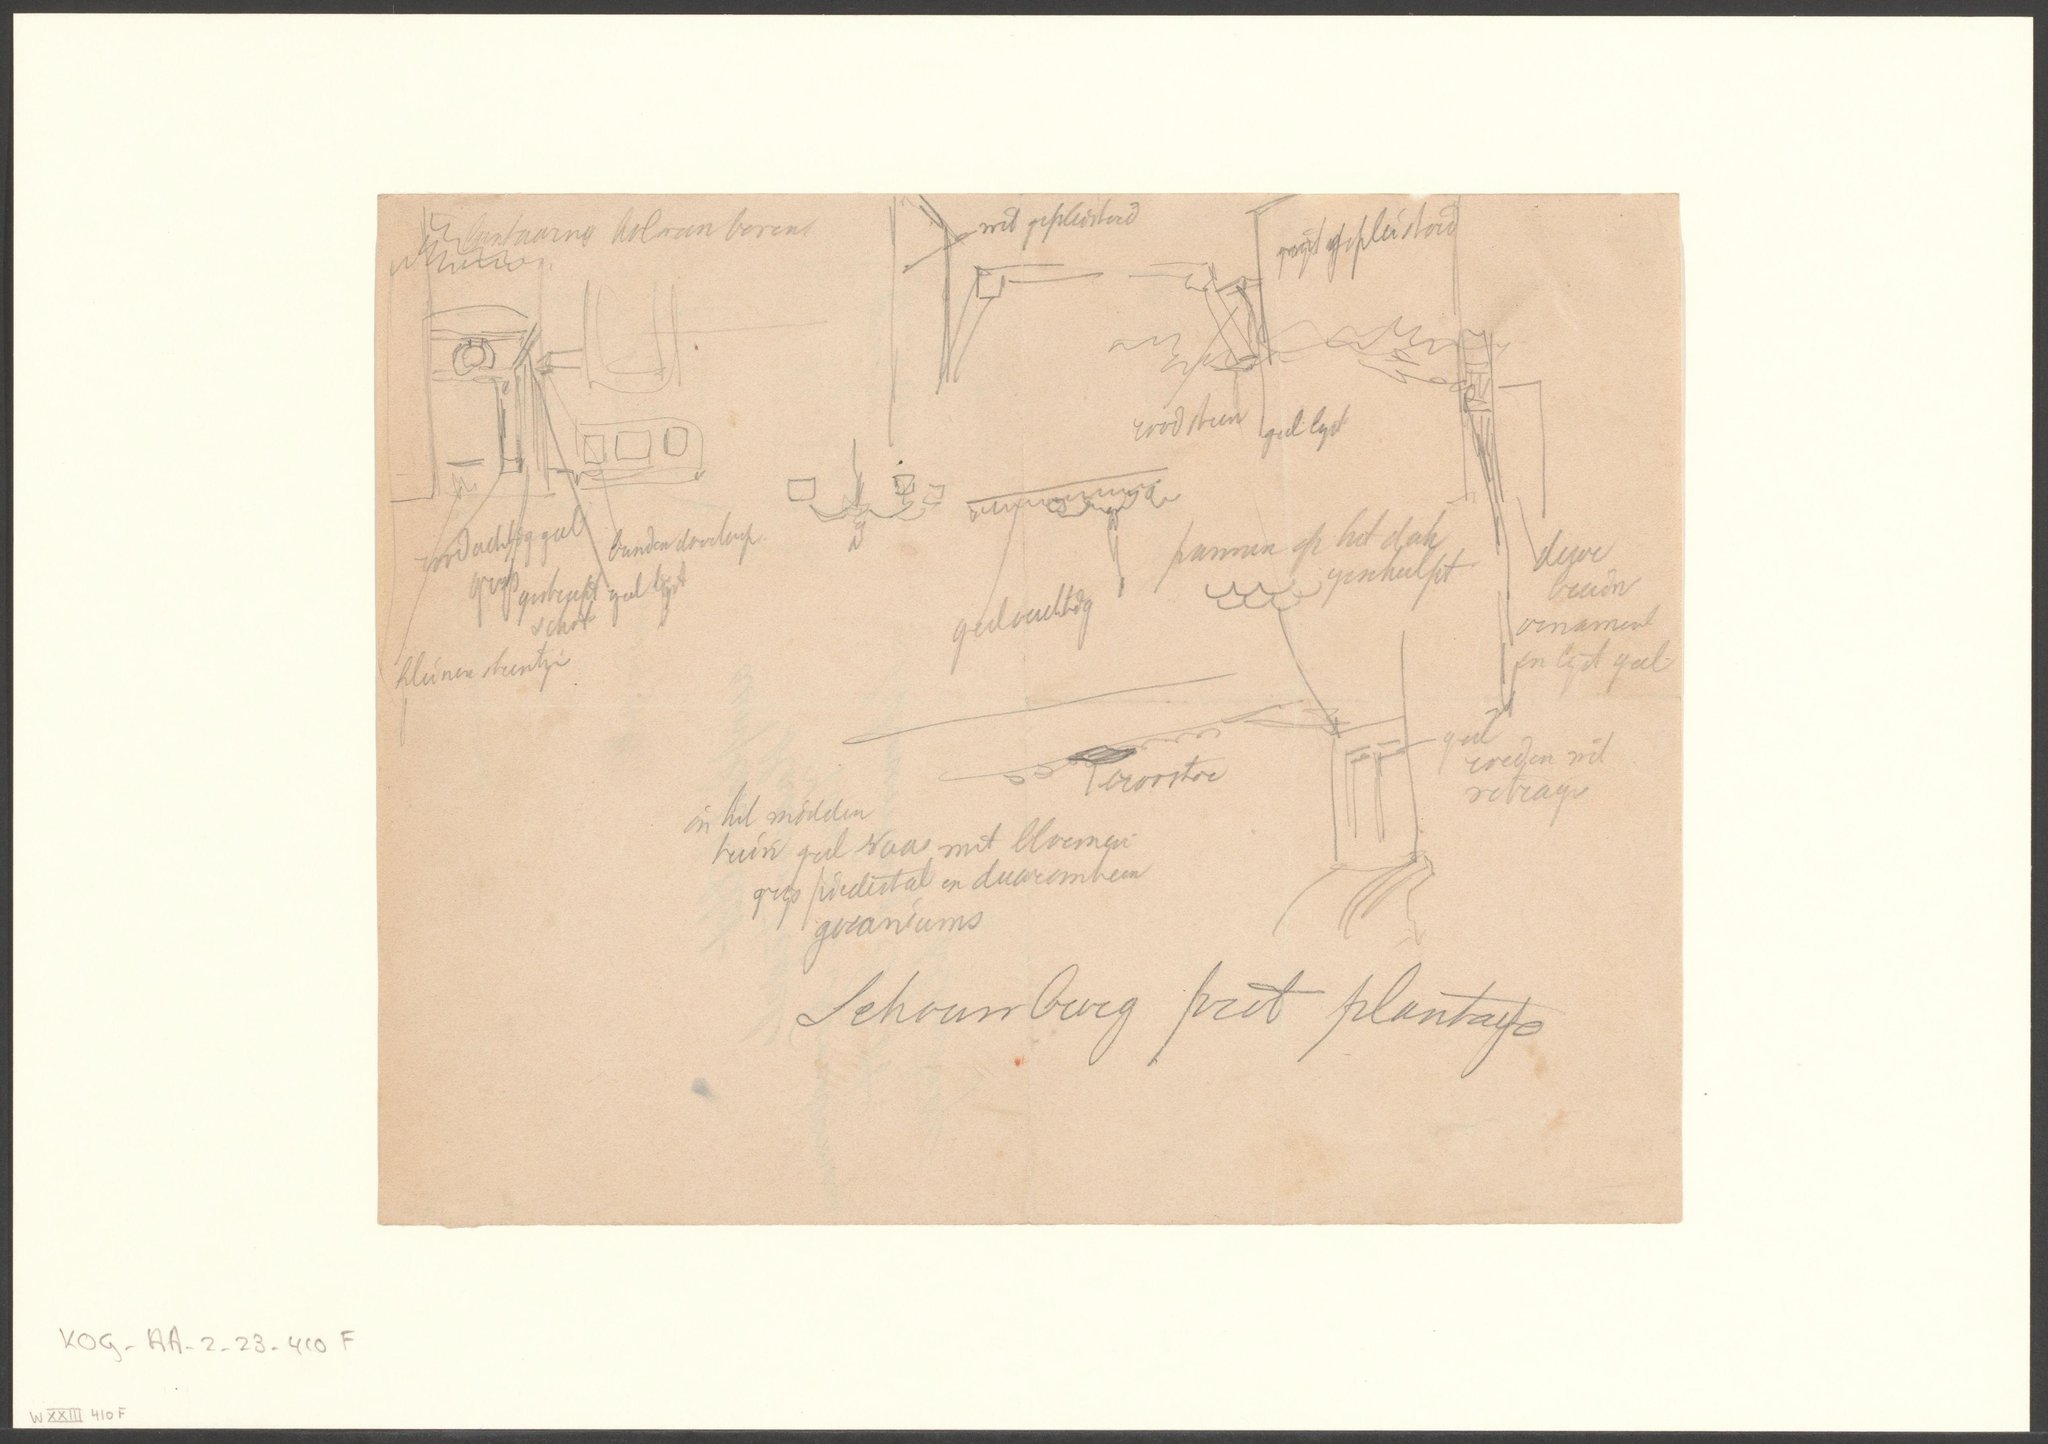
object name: drawing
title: Compositie met details van Theater Frascati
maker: johan george lodewijk rieke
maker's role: draughtsman, print maker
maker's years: 1817-1898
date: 1879-1889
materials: paper, pencil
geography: amsterdam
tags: theatre, theatrical performance, the stage and its equipment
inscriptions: inscription: ‘lantaarns h[...]en beren (...) schouwburg prot plantage’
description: Tekening binnen de Atlas Van Eck ingedeeld op wijknummer 23.